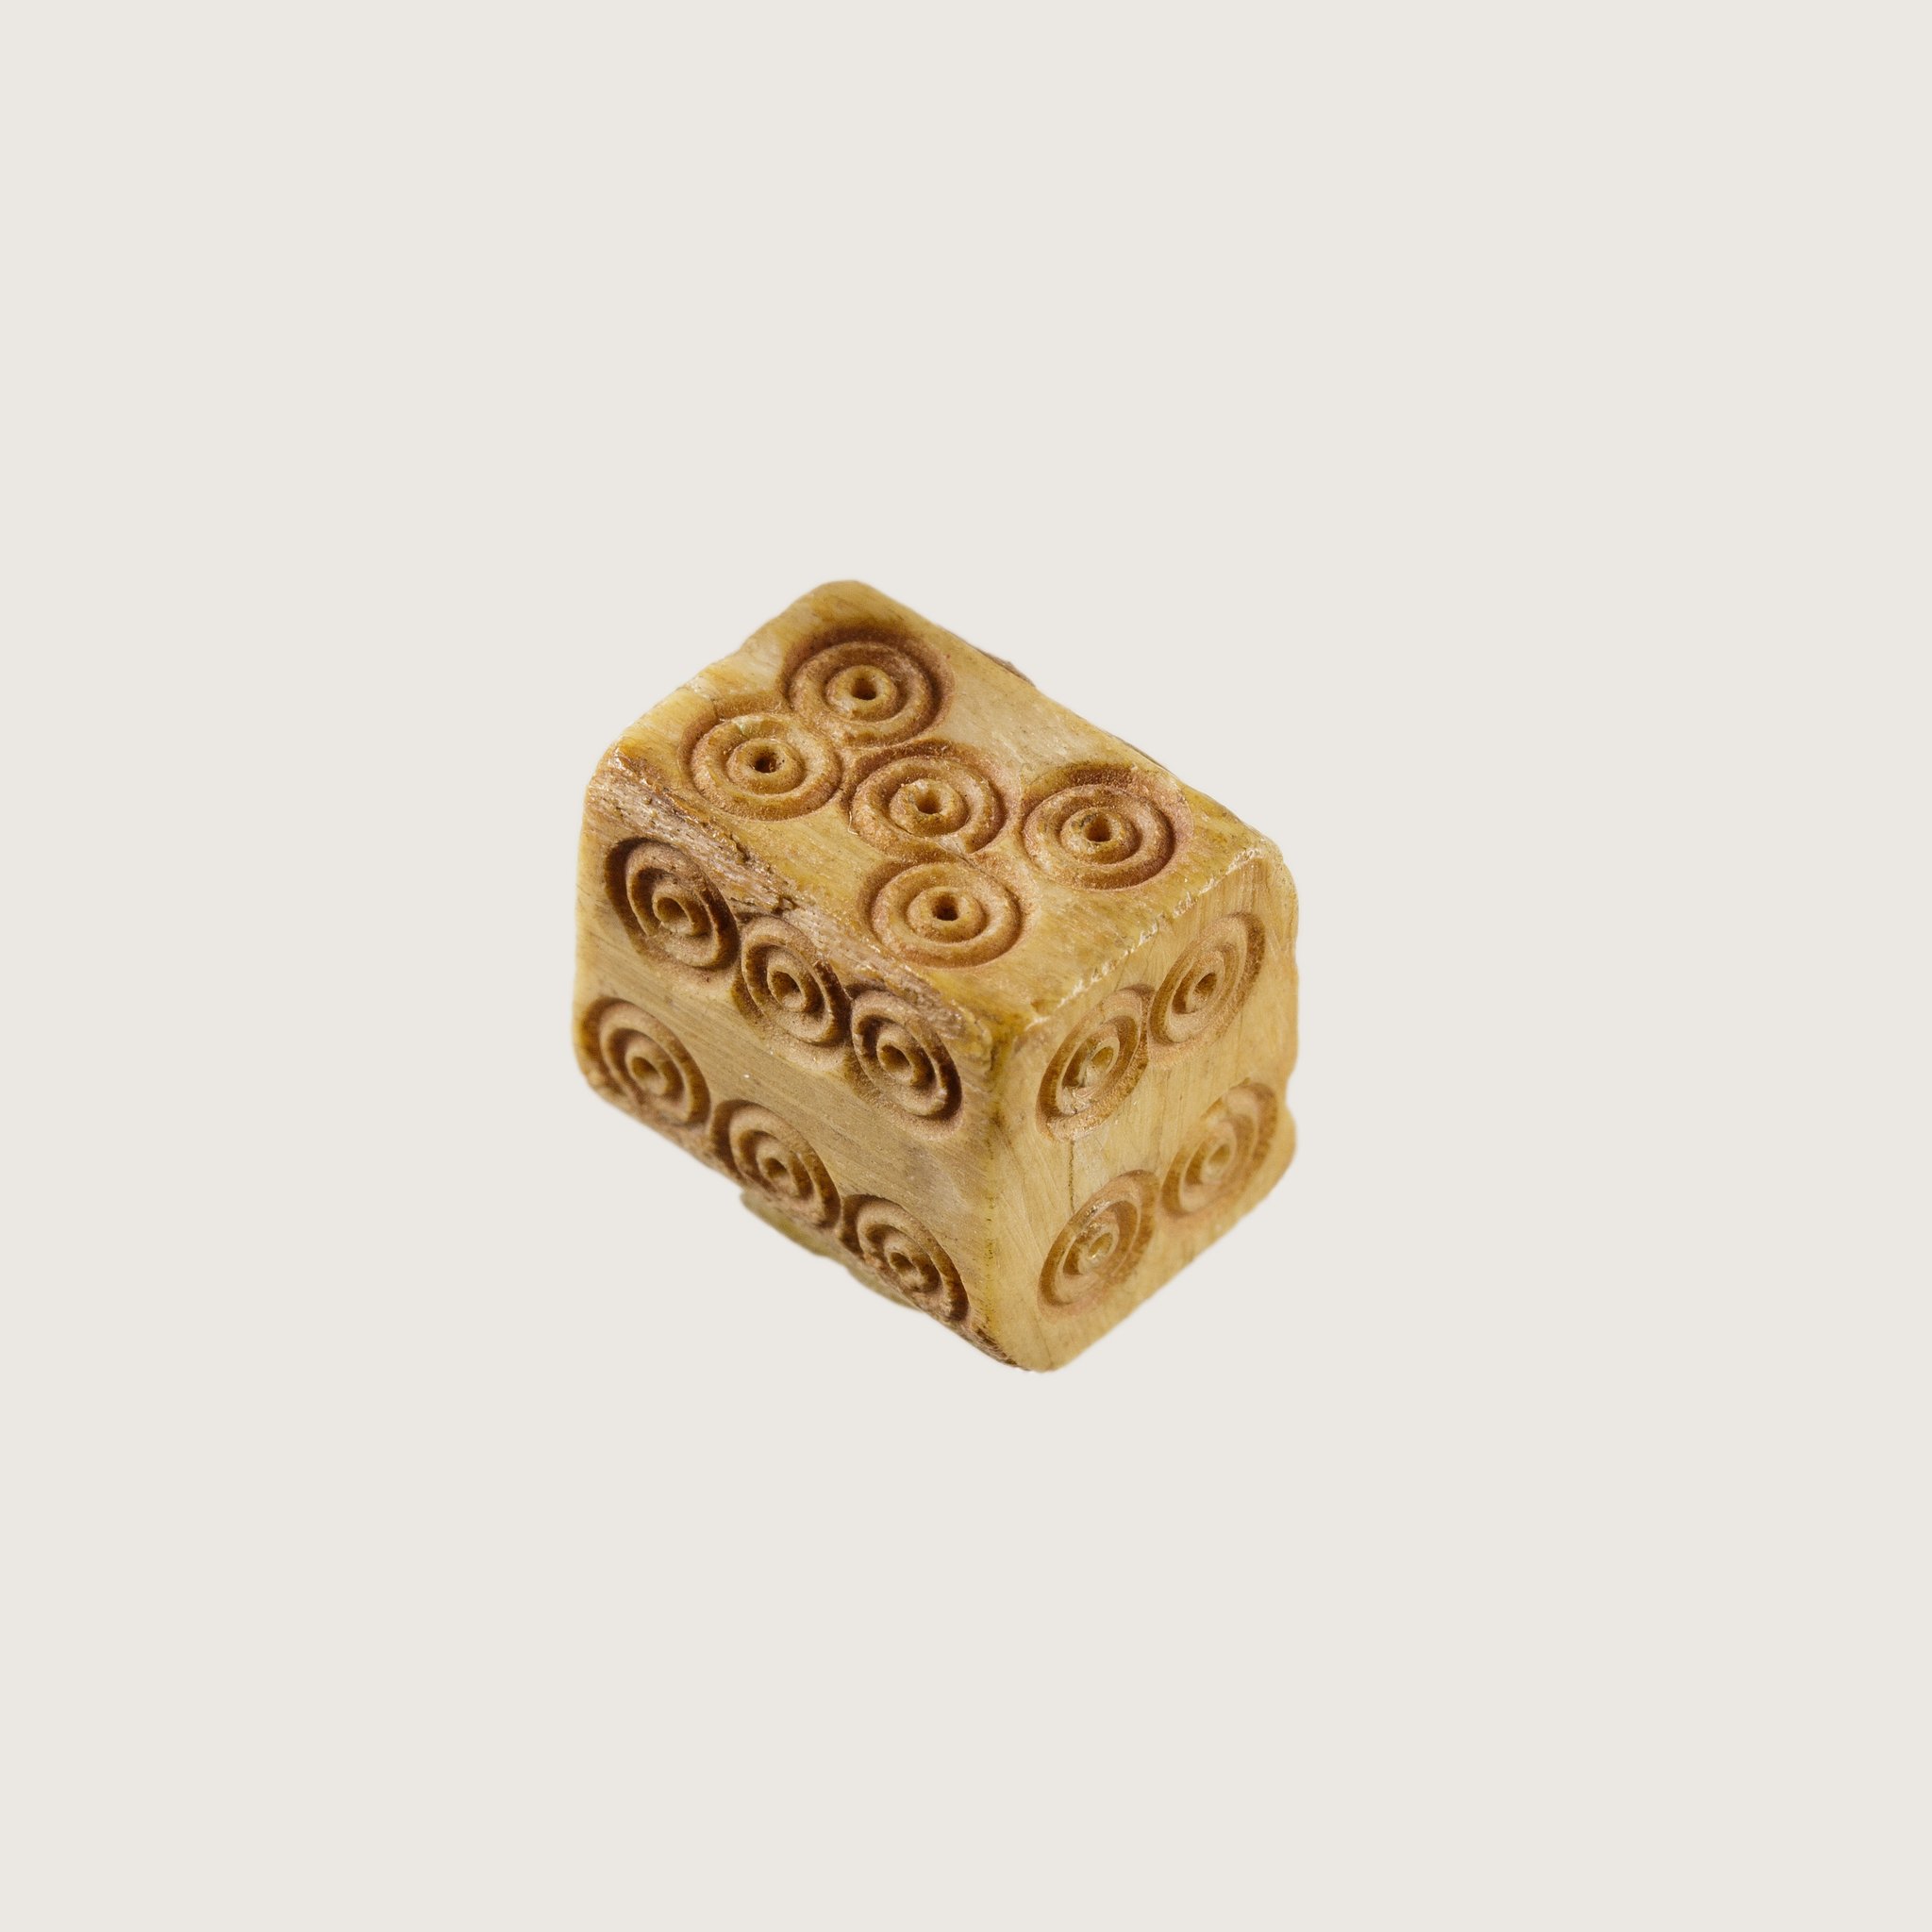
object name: dice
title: Die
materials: ivory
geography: egypt